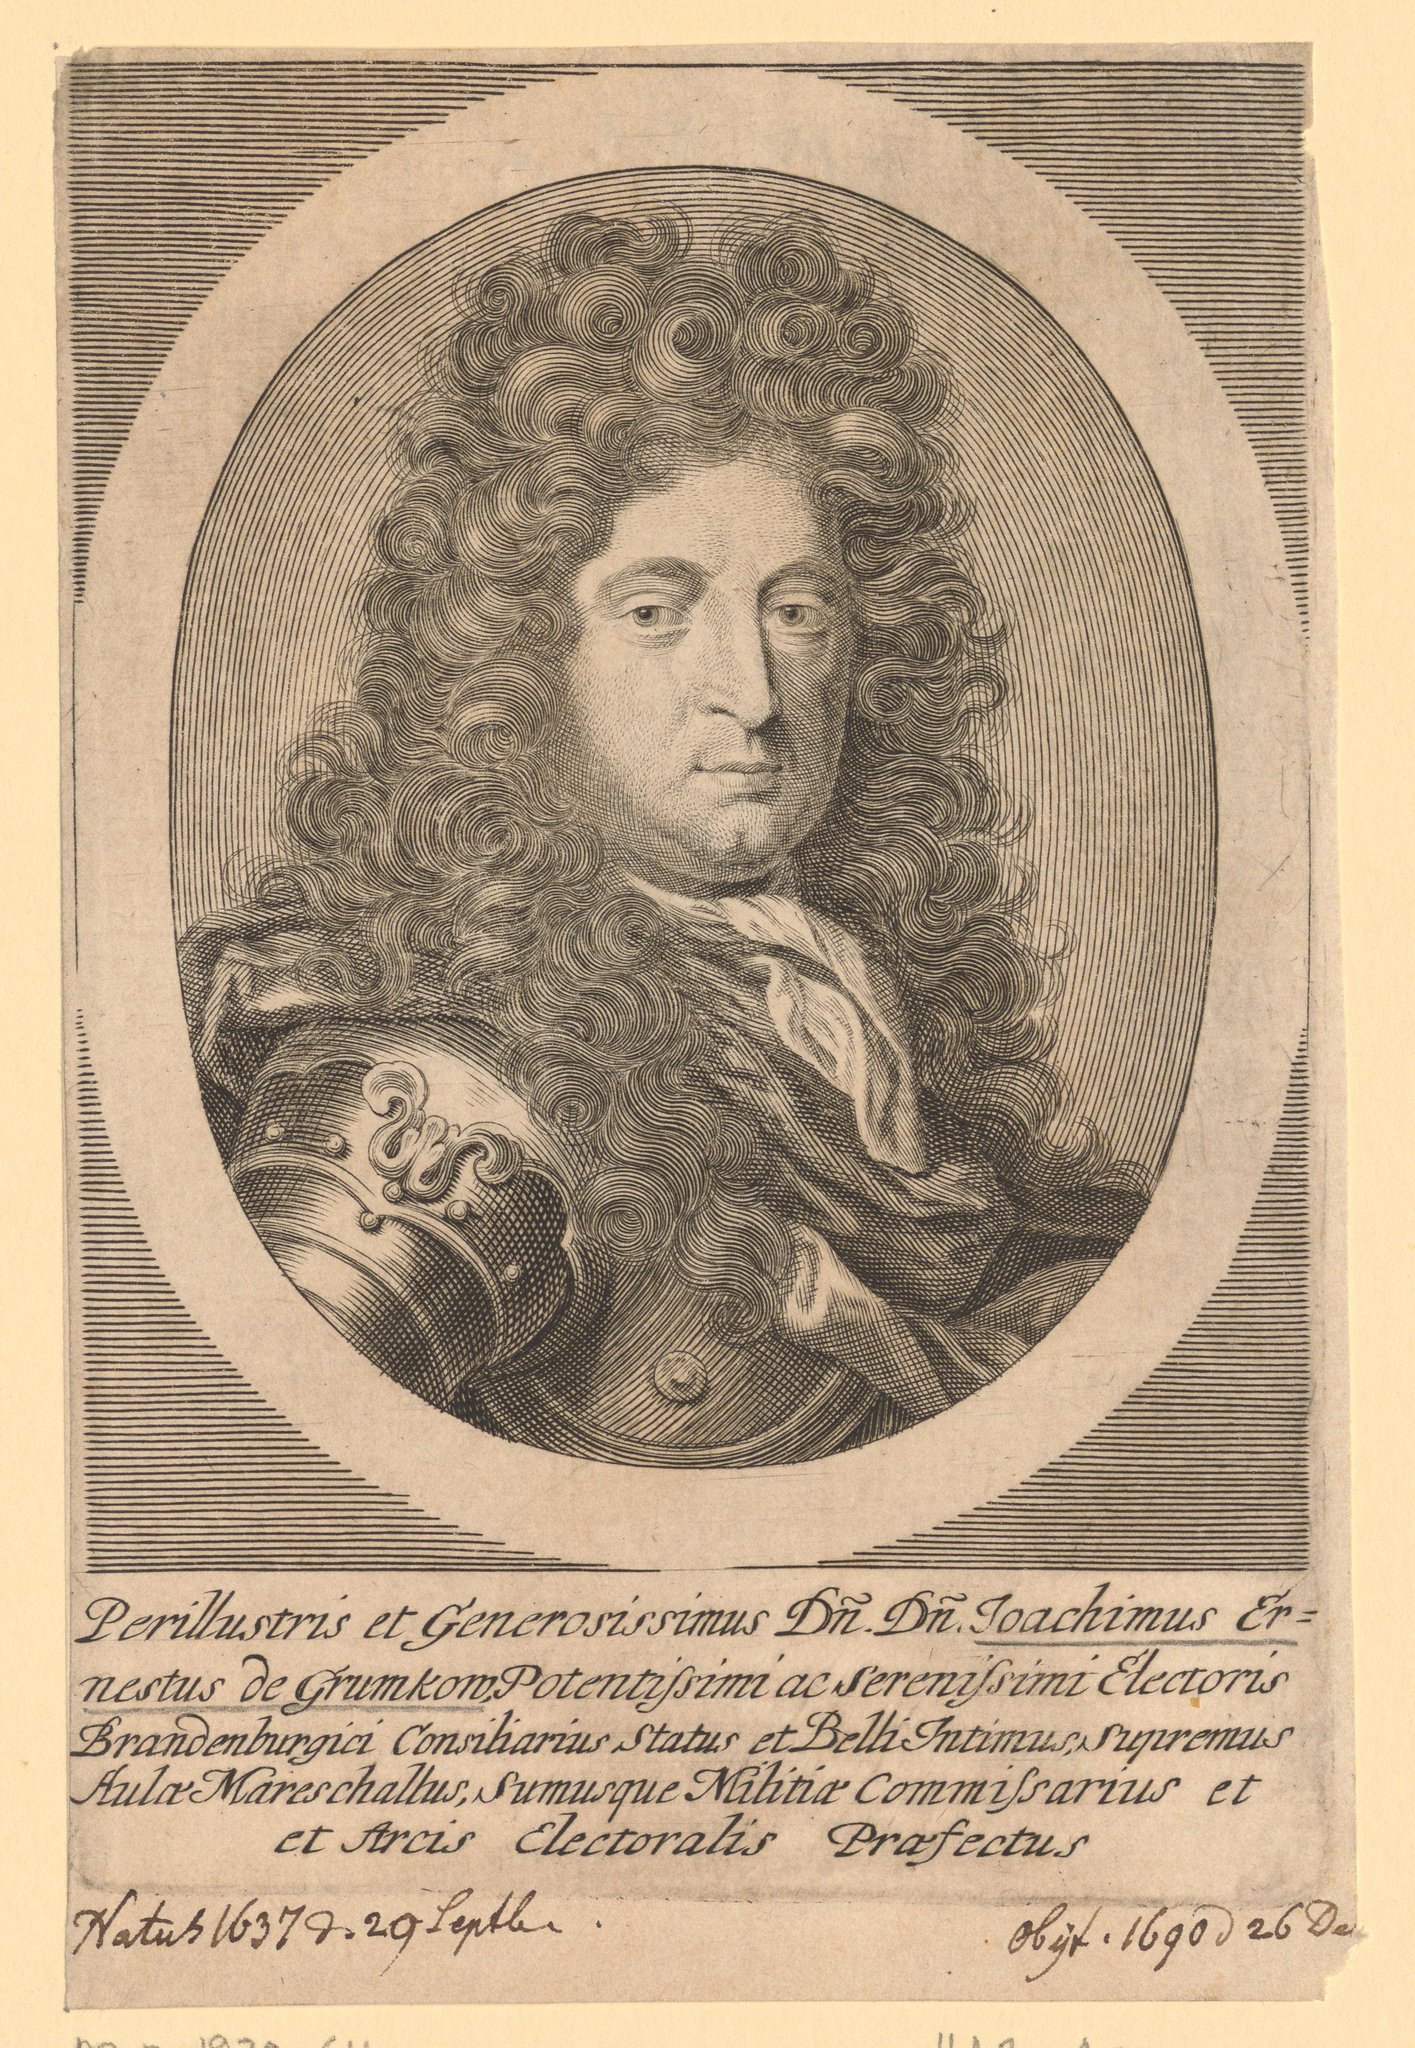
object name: print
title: Portret van Joachim Ernestus Gramkow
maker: Anonymous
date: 1647-1691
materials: paper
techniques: engraving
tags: politician, historical persons, officer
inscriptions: collector's mark: Lugt 2228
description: Prent mogelijk uit: Theatrum Europaeum (...). Frankfurt am Main: Matthäus Merian (II), 1691, dl. 12.